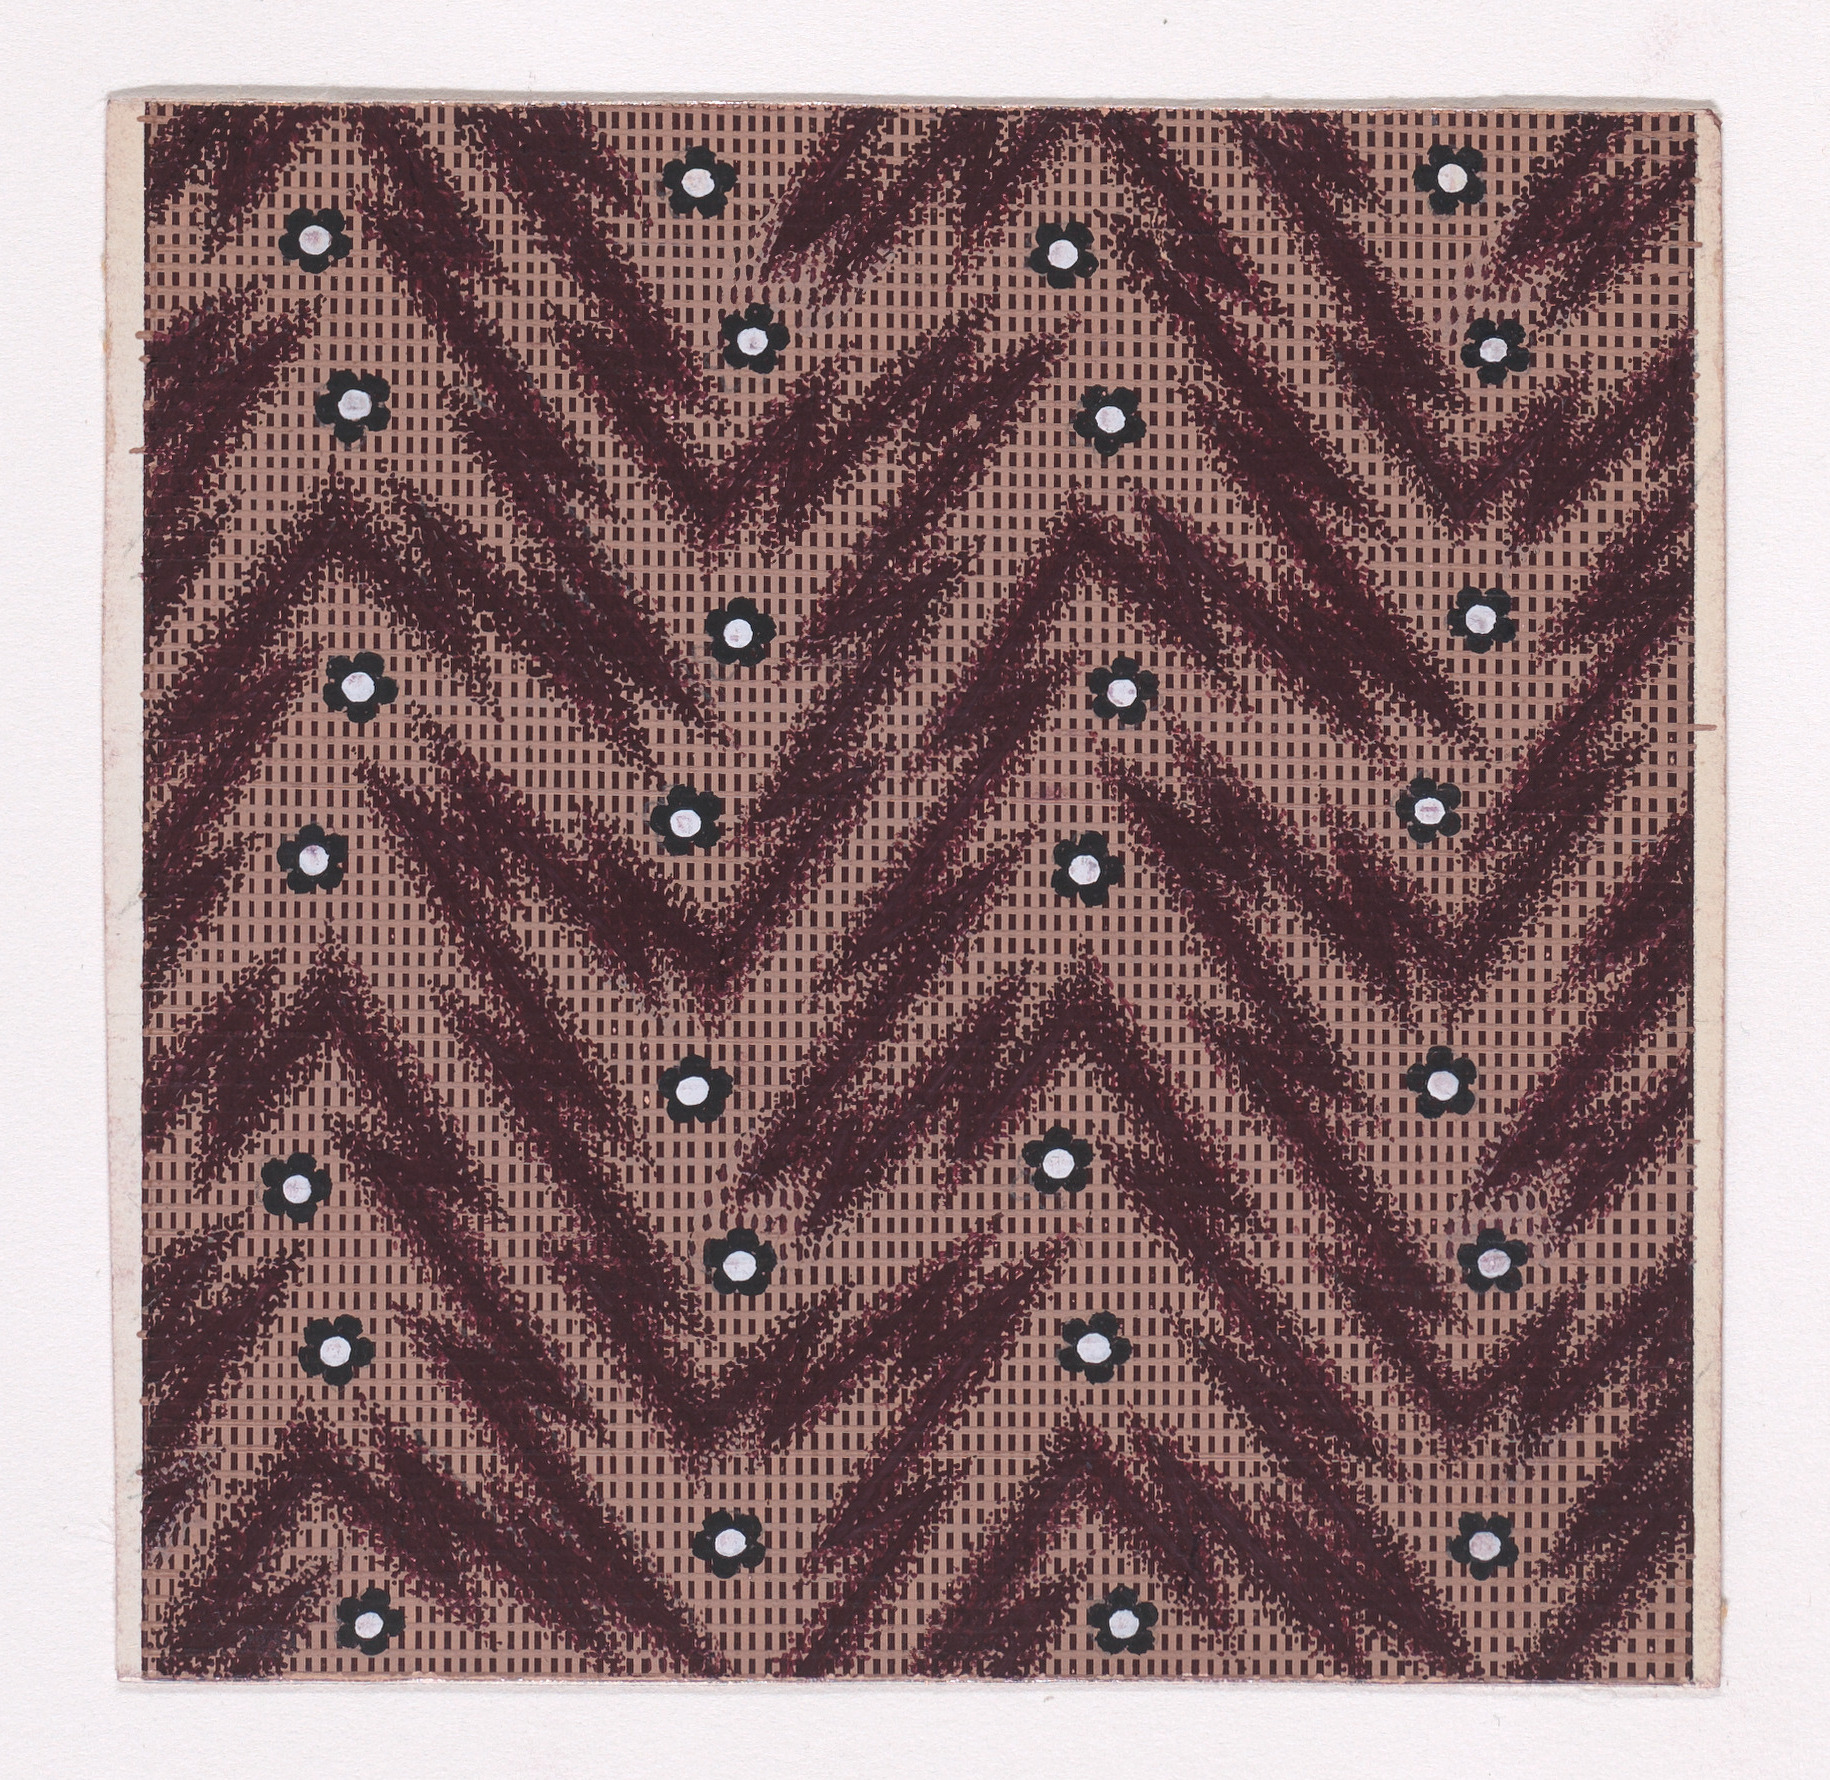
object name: drawing ornament architecture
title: Textile Design with Rosettes and Pearls over a Checked Background with Zig-Zagging Lines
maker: anonymous, alsatian, 19th century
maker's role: artist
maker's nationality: alsatian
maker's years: 1800-1900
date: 1840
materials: gouache